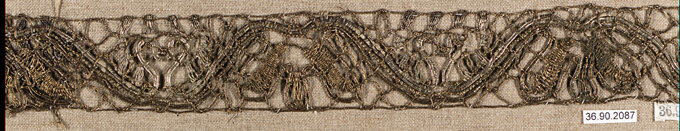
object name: piece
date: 1701-1800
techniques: lace